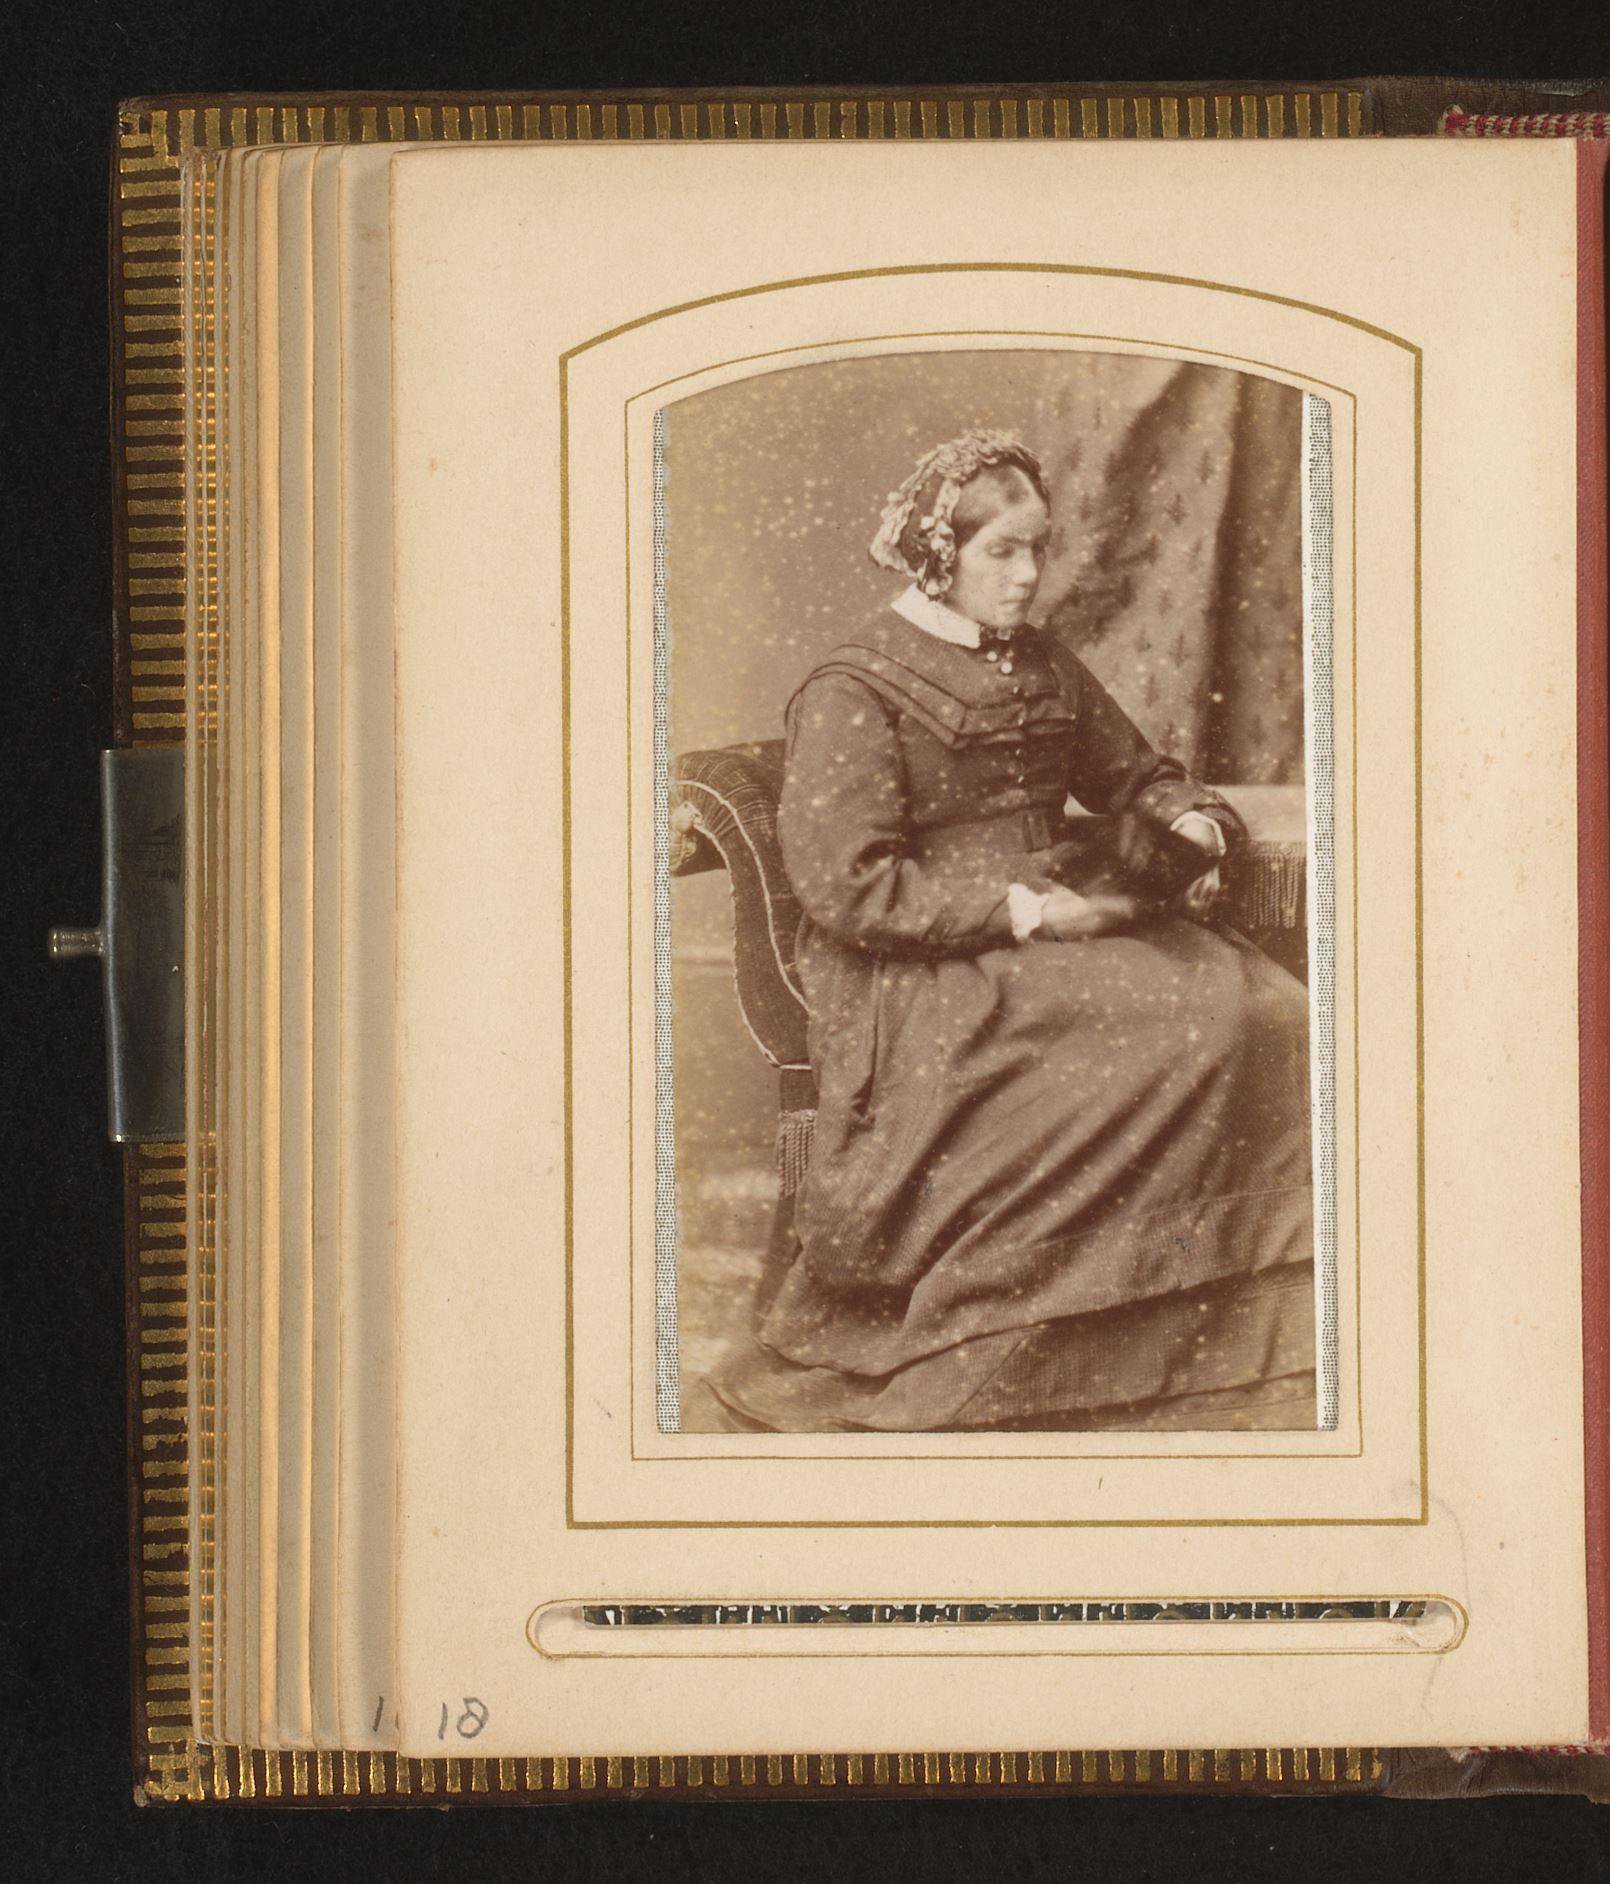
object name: carte de visite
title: Portret van een lezende vrouw, zittend op een stoel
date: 1874-1885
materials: cardboard, paper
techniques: albumen print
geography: yeovil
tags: historical persons - bb - woman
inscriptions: inscription: ‘AWARDED FIRST PRIZE OF/ L 50/ FOR LIFE SIZE PORTRAITS TAKEN DIRECT FROM LIFE/ LONDON EXHIBITION, PALL MALL, 1874/ JNO CHAFFIN & SONS/ YEOVIL’